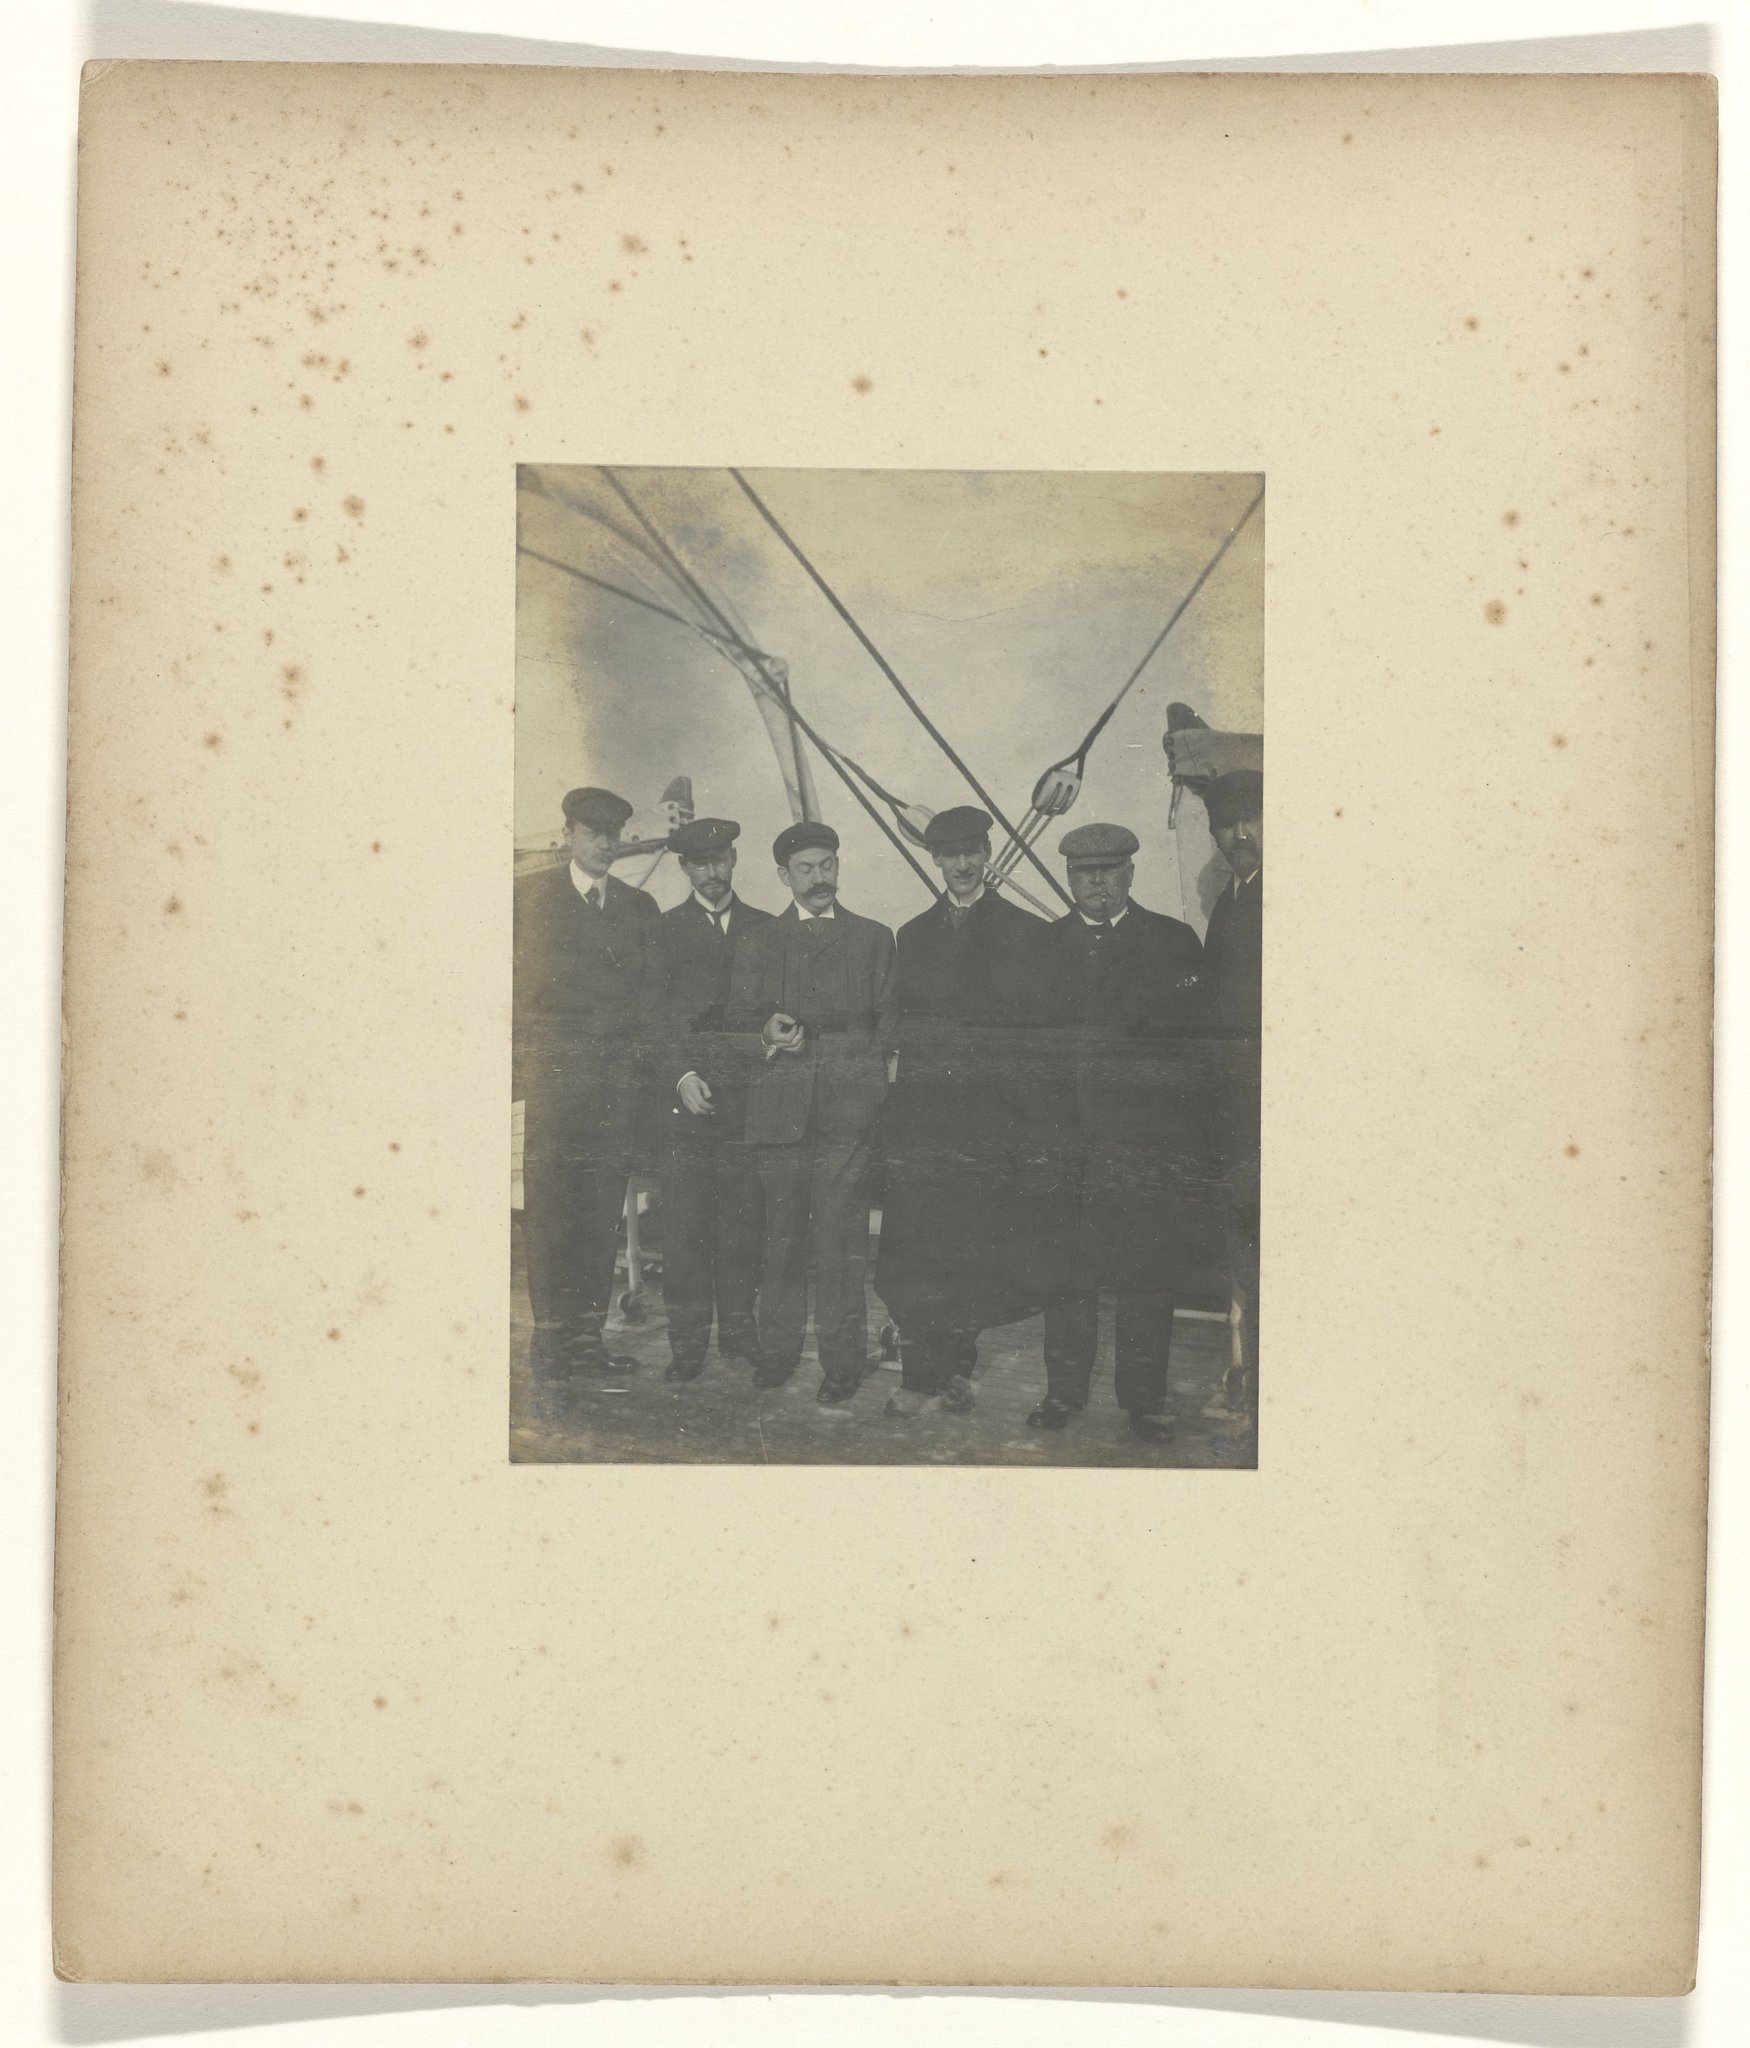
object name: photograph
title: Groepsportret van zes mannen op het dek van een schip, met uiterst links Jan C. Schüller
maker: Anonymous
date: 1904-1905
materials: cardboard, paper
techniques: gelatin silver print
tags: painter, print maker, draughtsman, jan schüller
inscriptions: annotation: ‘links Jan C. Schüller’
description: Groepsportret van zes mannen op het dek van een schip, met uiterst links Jan C. Schüller.